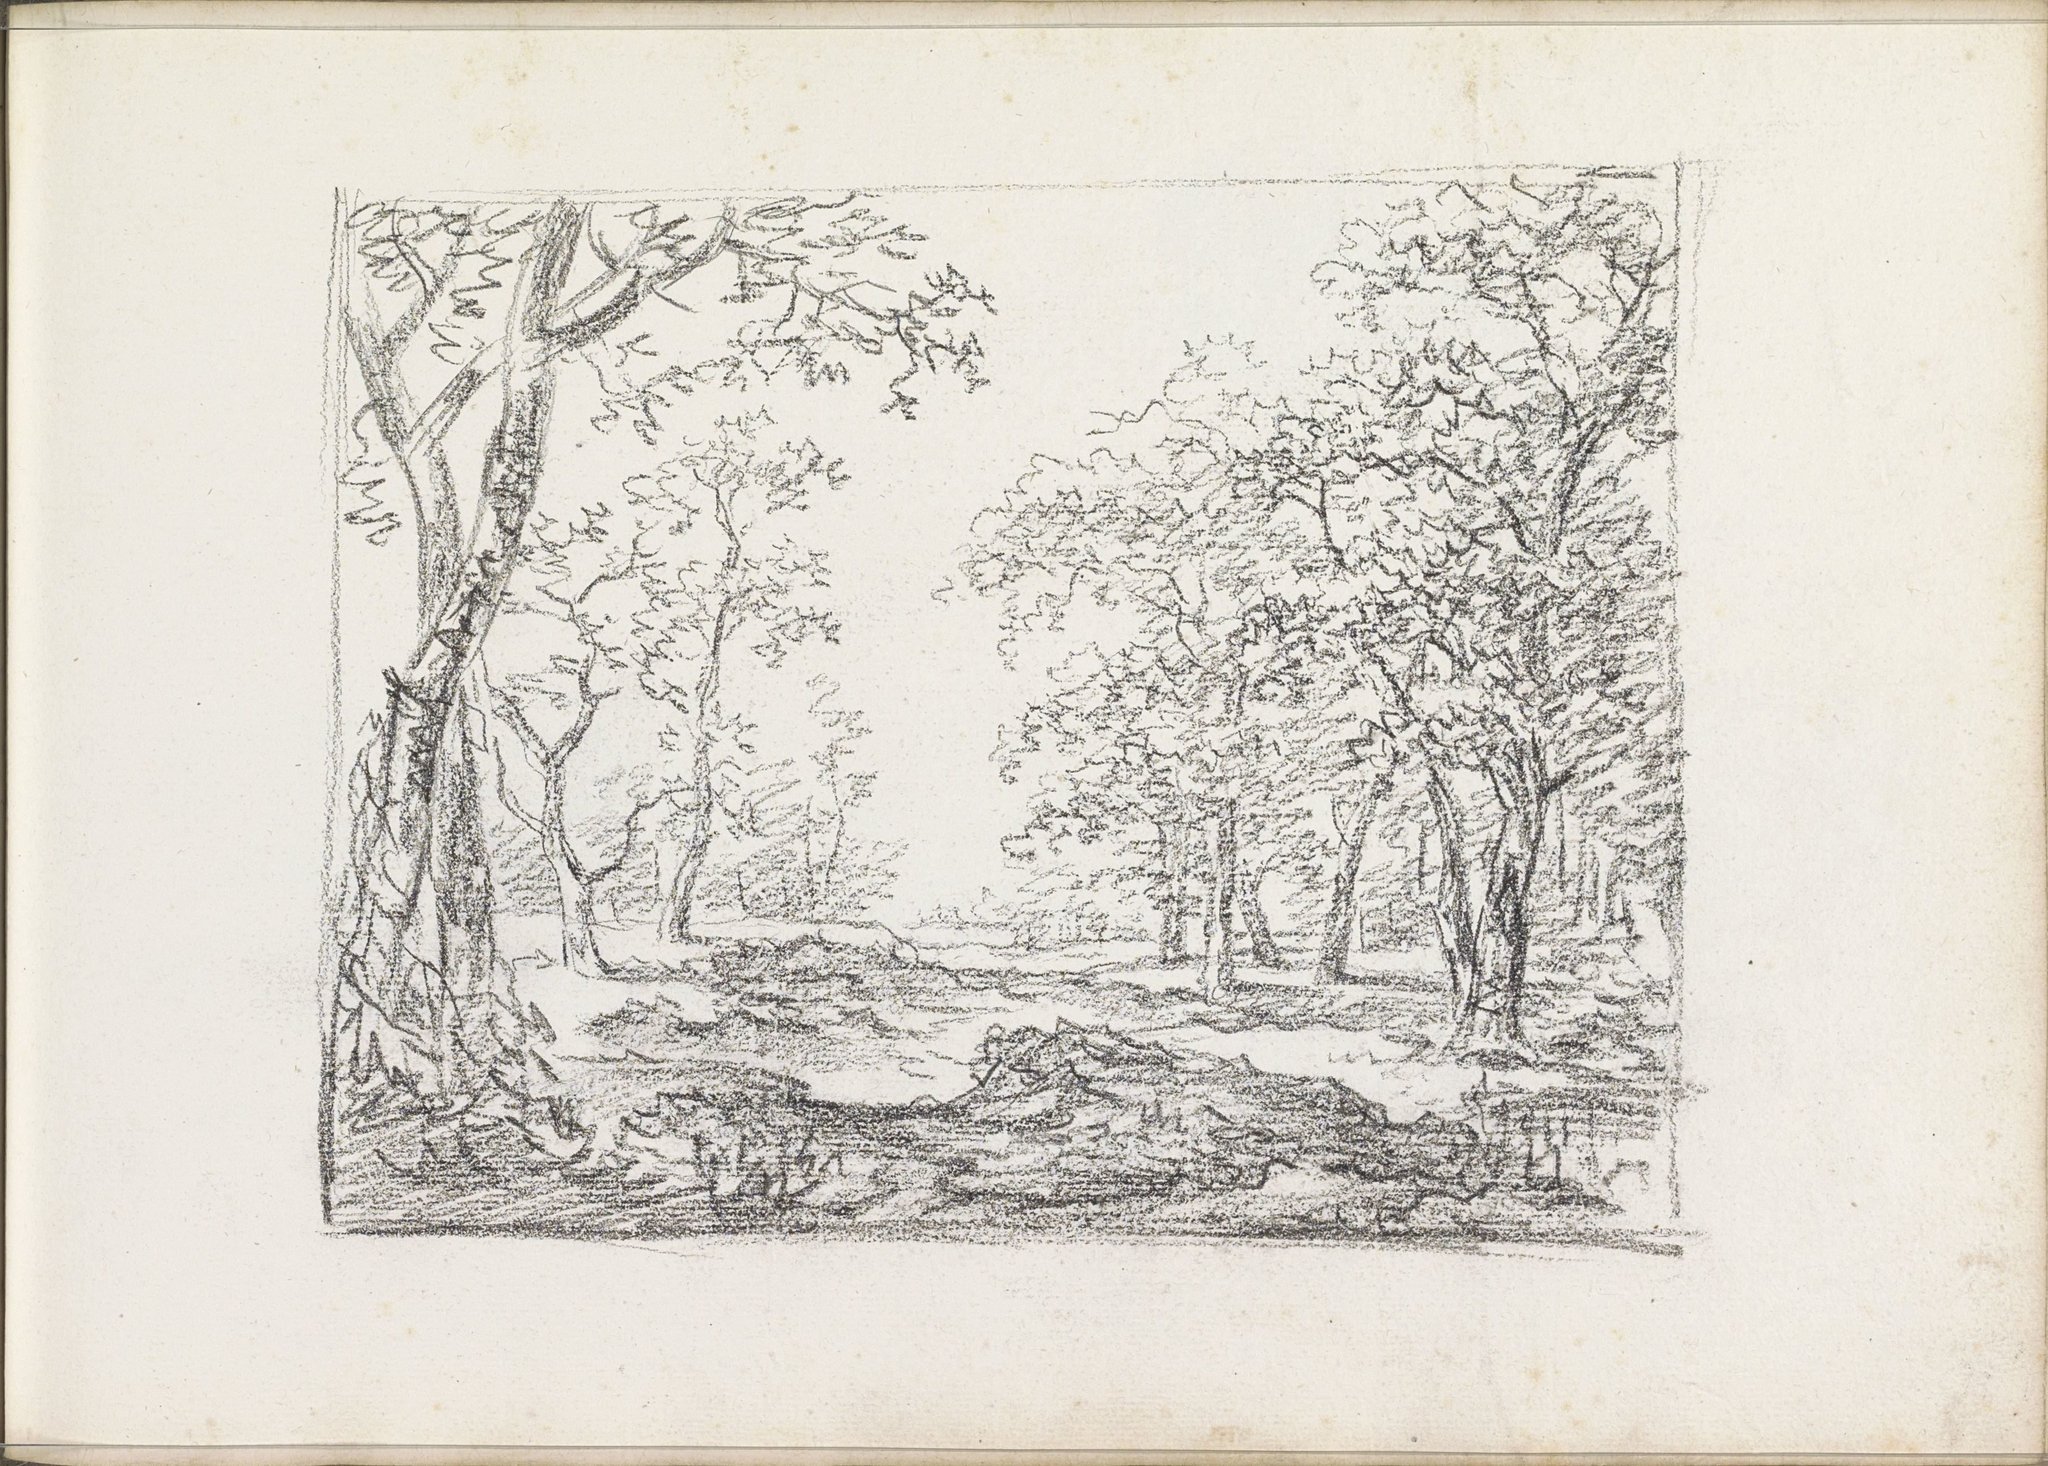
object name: sketchbook leaf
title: Landschap met bomen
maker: andreas schelfhout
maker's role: draughtsman, painter, print maker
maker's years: 1787-1870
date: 1811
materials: chalk, paper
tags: trees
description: Blad 56 recto uit een schetsboek met 75 bladen.